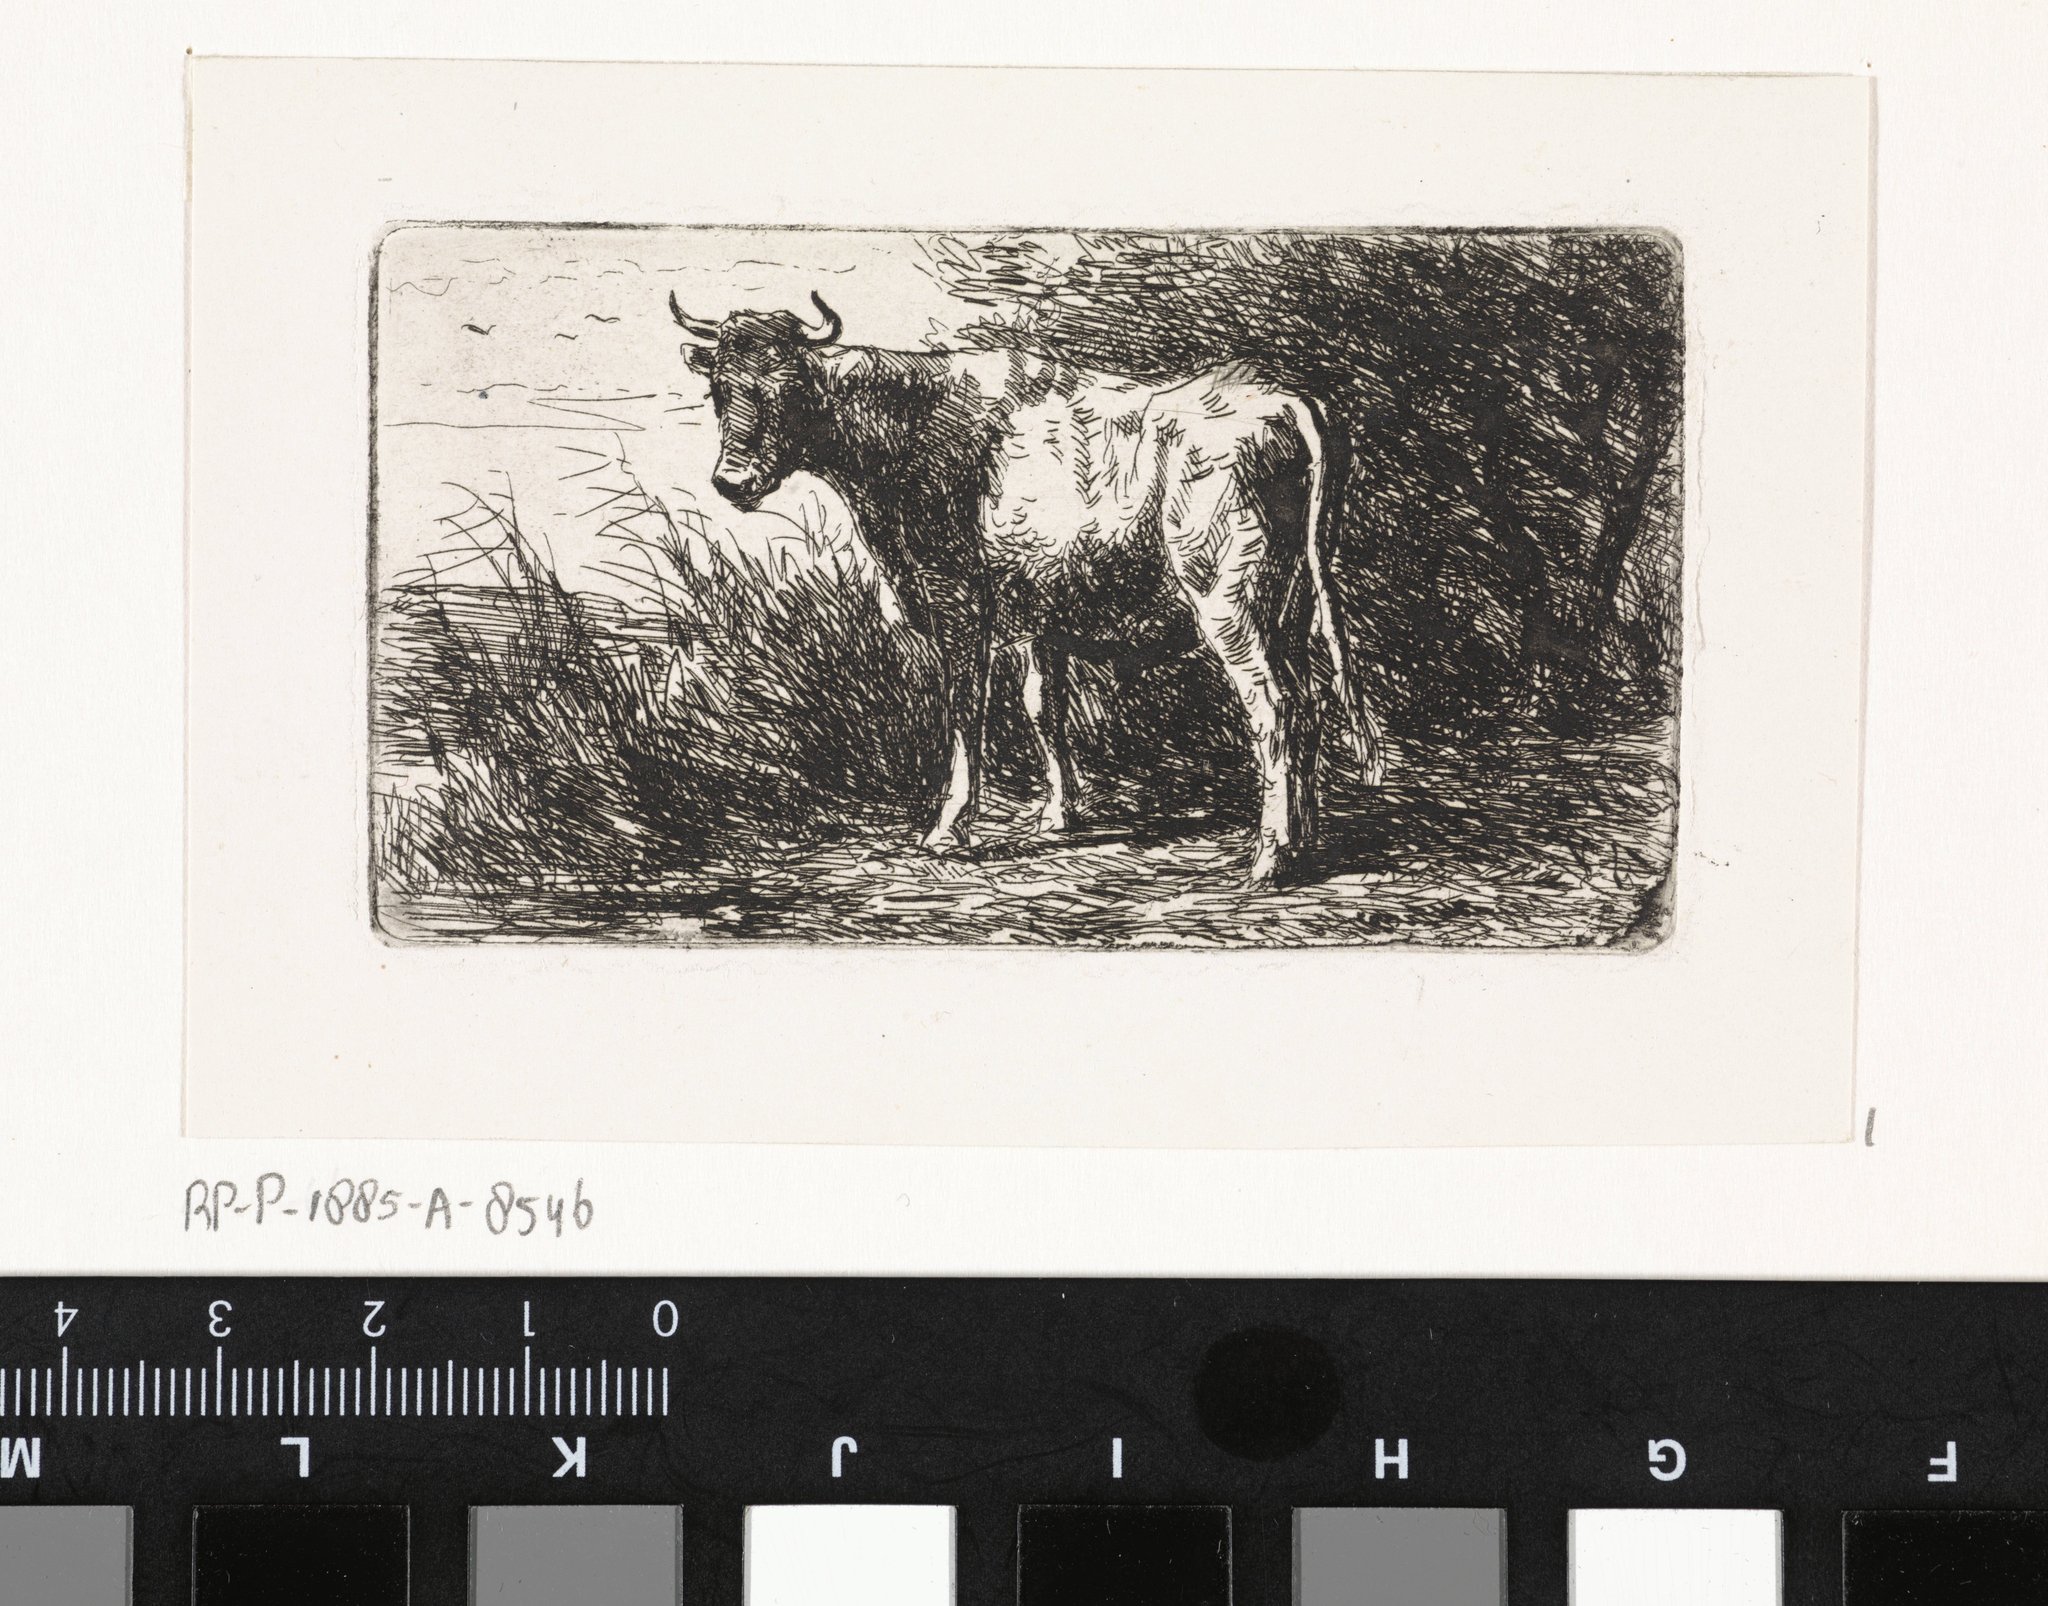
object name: print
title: Koe aan de oever van een rivier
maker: jan vrolijk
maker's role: draughtsman, painter, print maker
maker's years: 1846-1894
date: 1860-1885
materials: paper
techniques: etching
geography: the hague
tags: cow, river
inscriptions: collector's mark: Lugt 2228